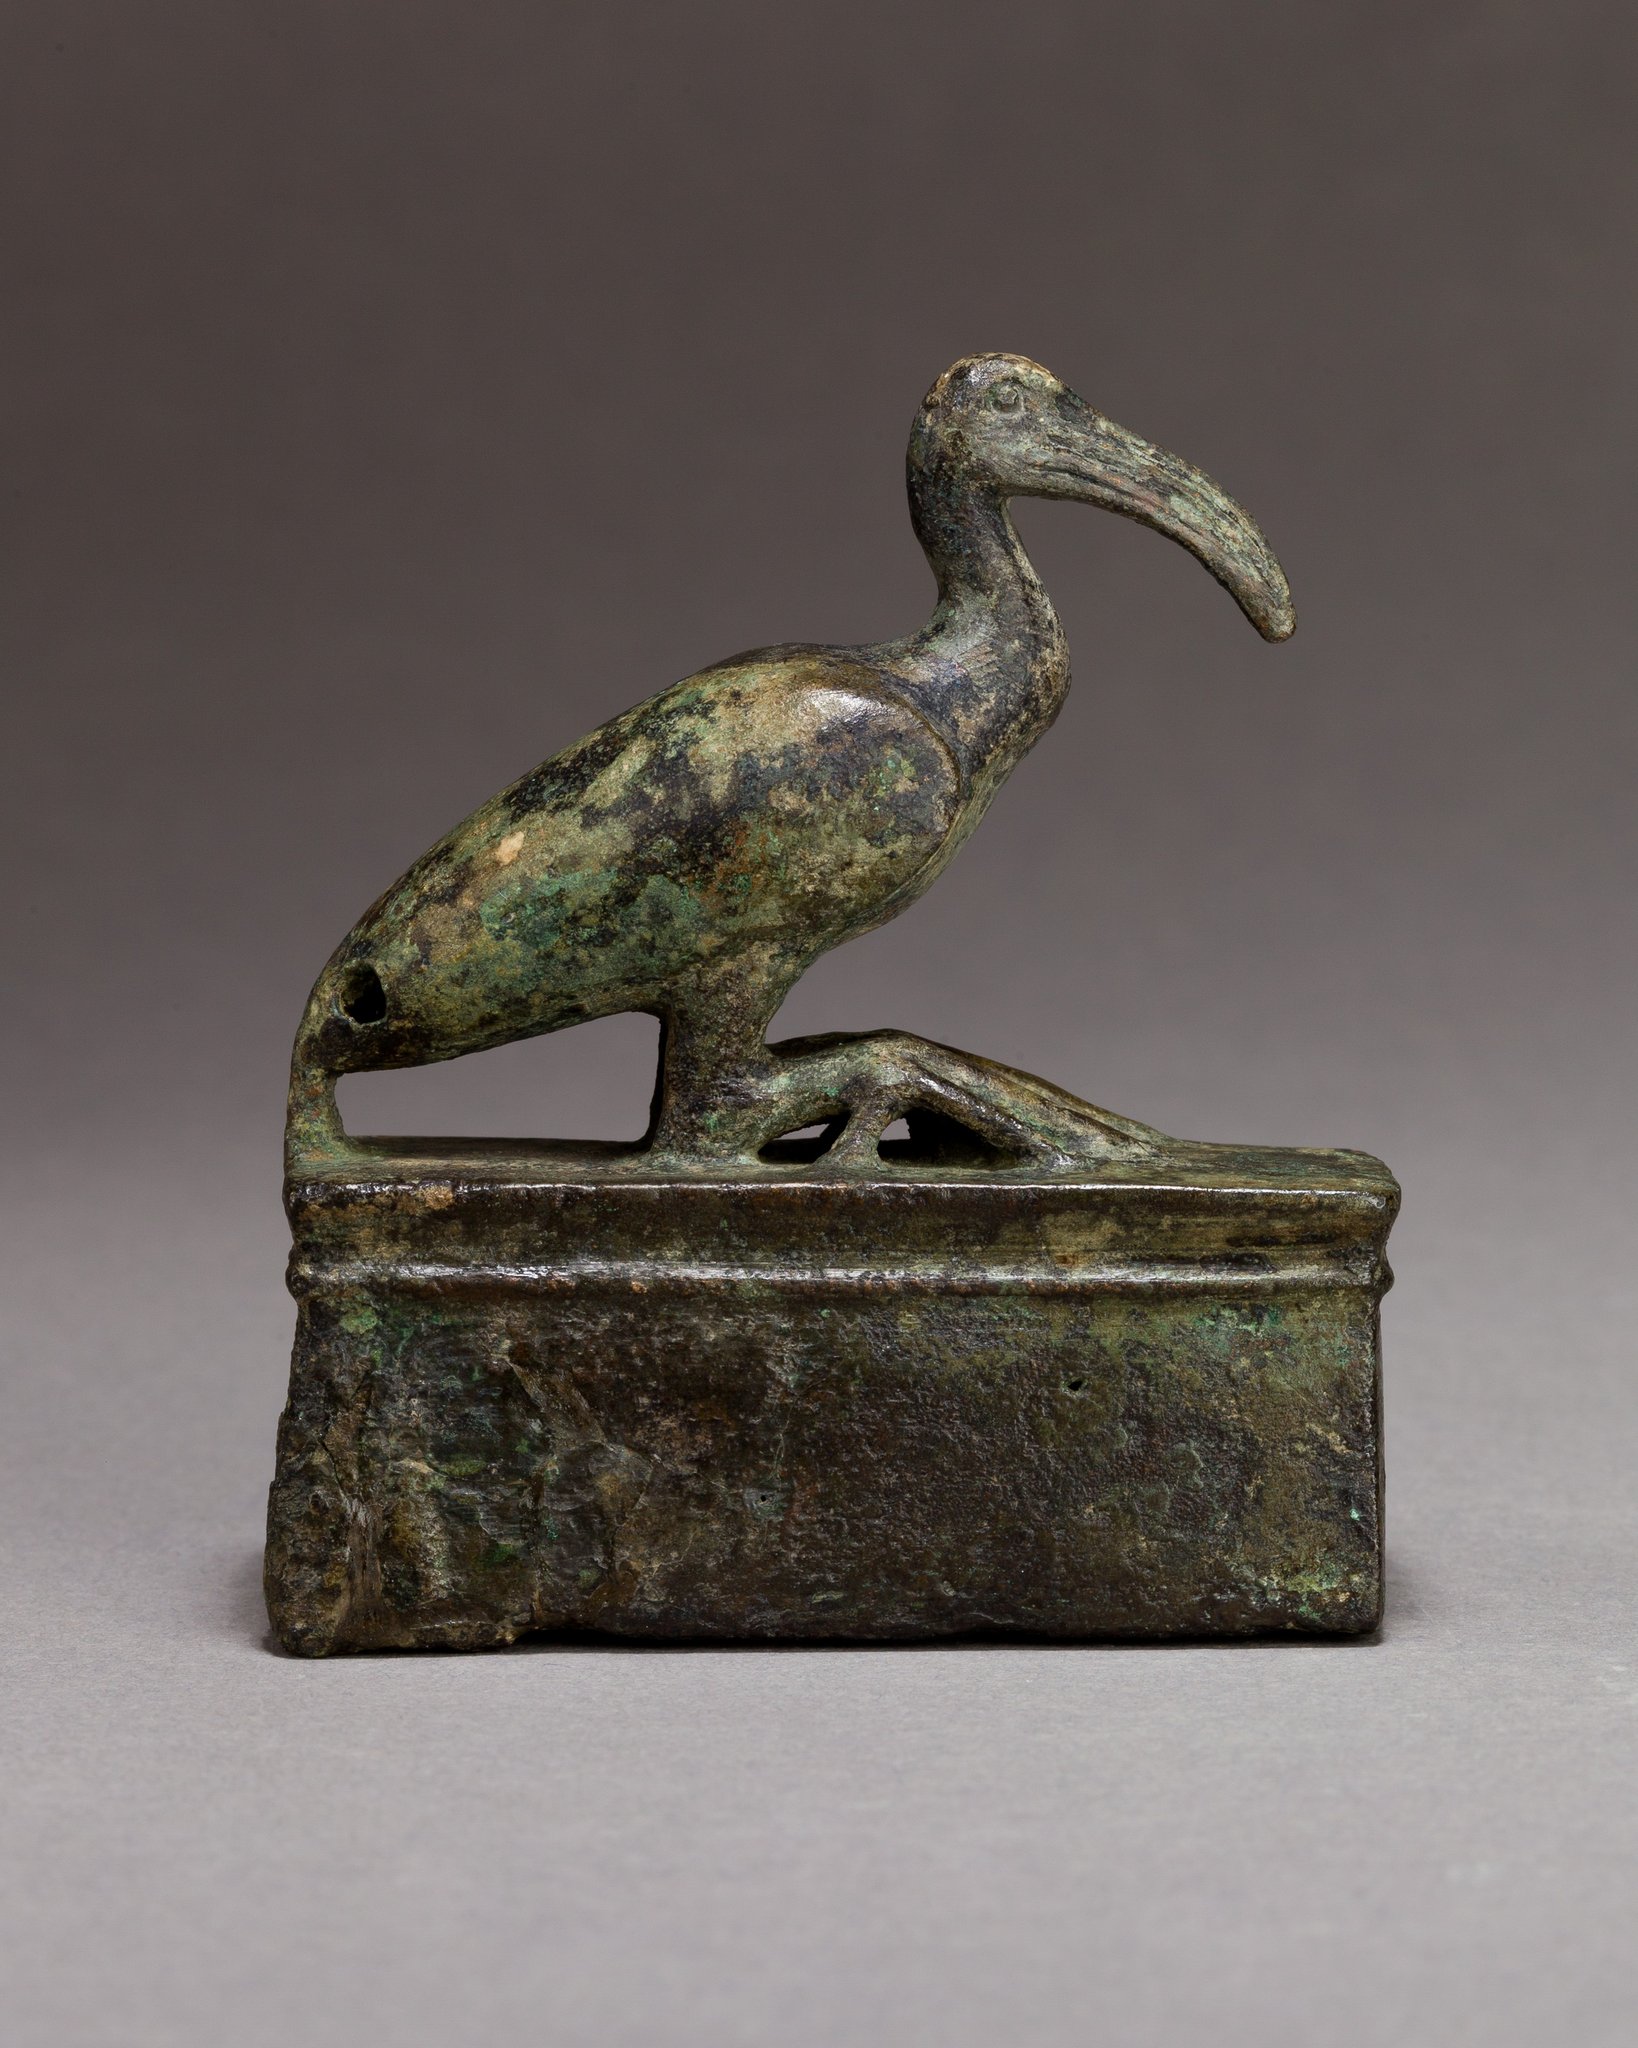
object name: coffin box, ibis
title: Ibis on a shrine shaped box, probably for an animal mummy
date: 664-630 BCE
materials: metal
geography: egypt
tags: birds,coffins